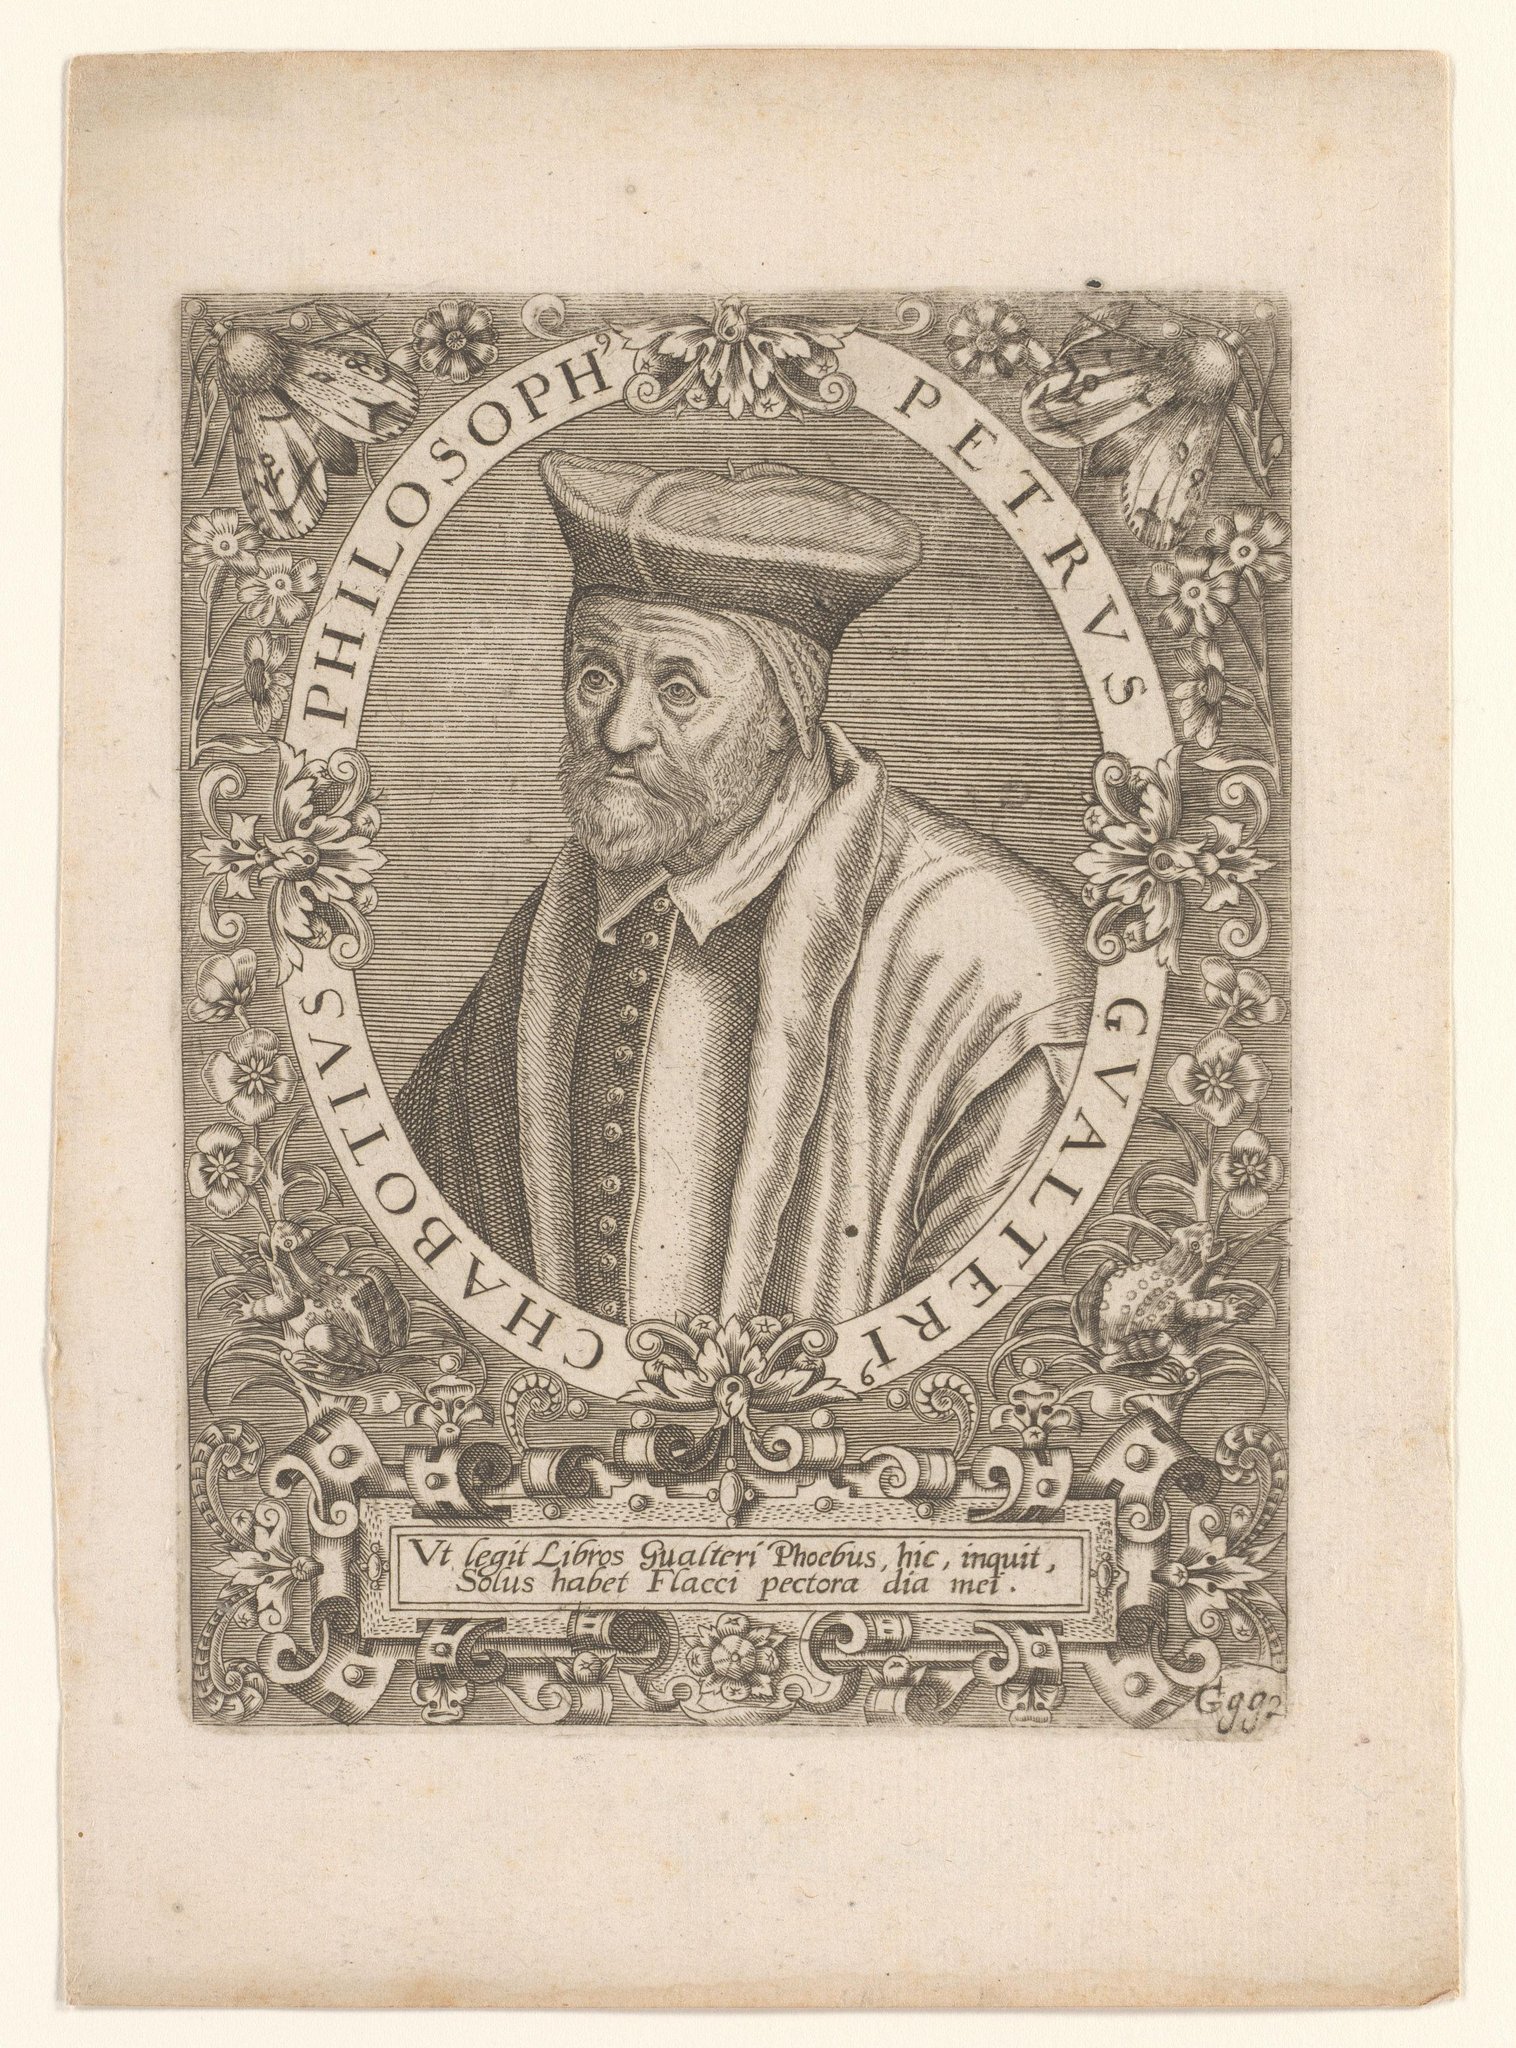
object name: book illustration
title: Petrus Gualteri[9] Chabotius philosoph[9]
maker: jean jacques boissard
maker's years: 1528-1598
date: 1650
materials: paper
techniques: engraving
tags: scholar, philosopher, historical persons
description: Prent gebruikt in: Boissard, Jean Jacques. Bibliotheca chalcographica. 8 dln. Frankfurt am Main: Johannes Ammon, 1650-1652. Ook gebruikt in latere edities. Eerdere staat van prent verschenen in: Boissard, Jean Jacques. Icones quinquaginta virorum illustrium doctrina & eruditione praestantium ad vivum effictae. 4 dln. Frankfurt am Main: s.n., 1597-1599. Mogelijk ook gebruikt in latere edities.